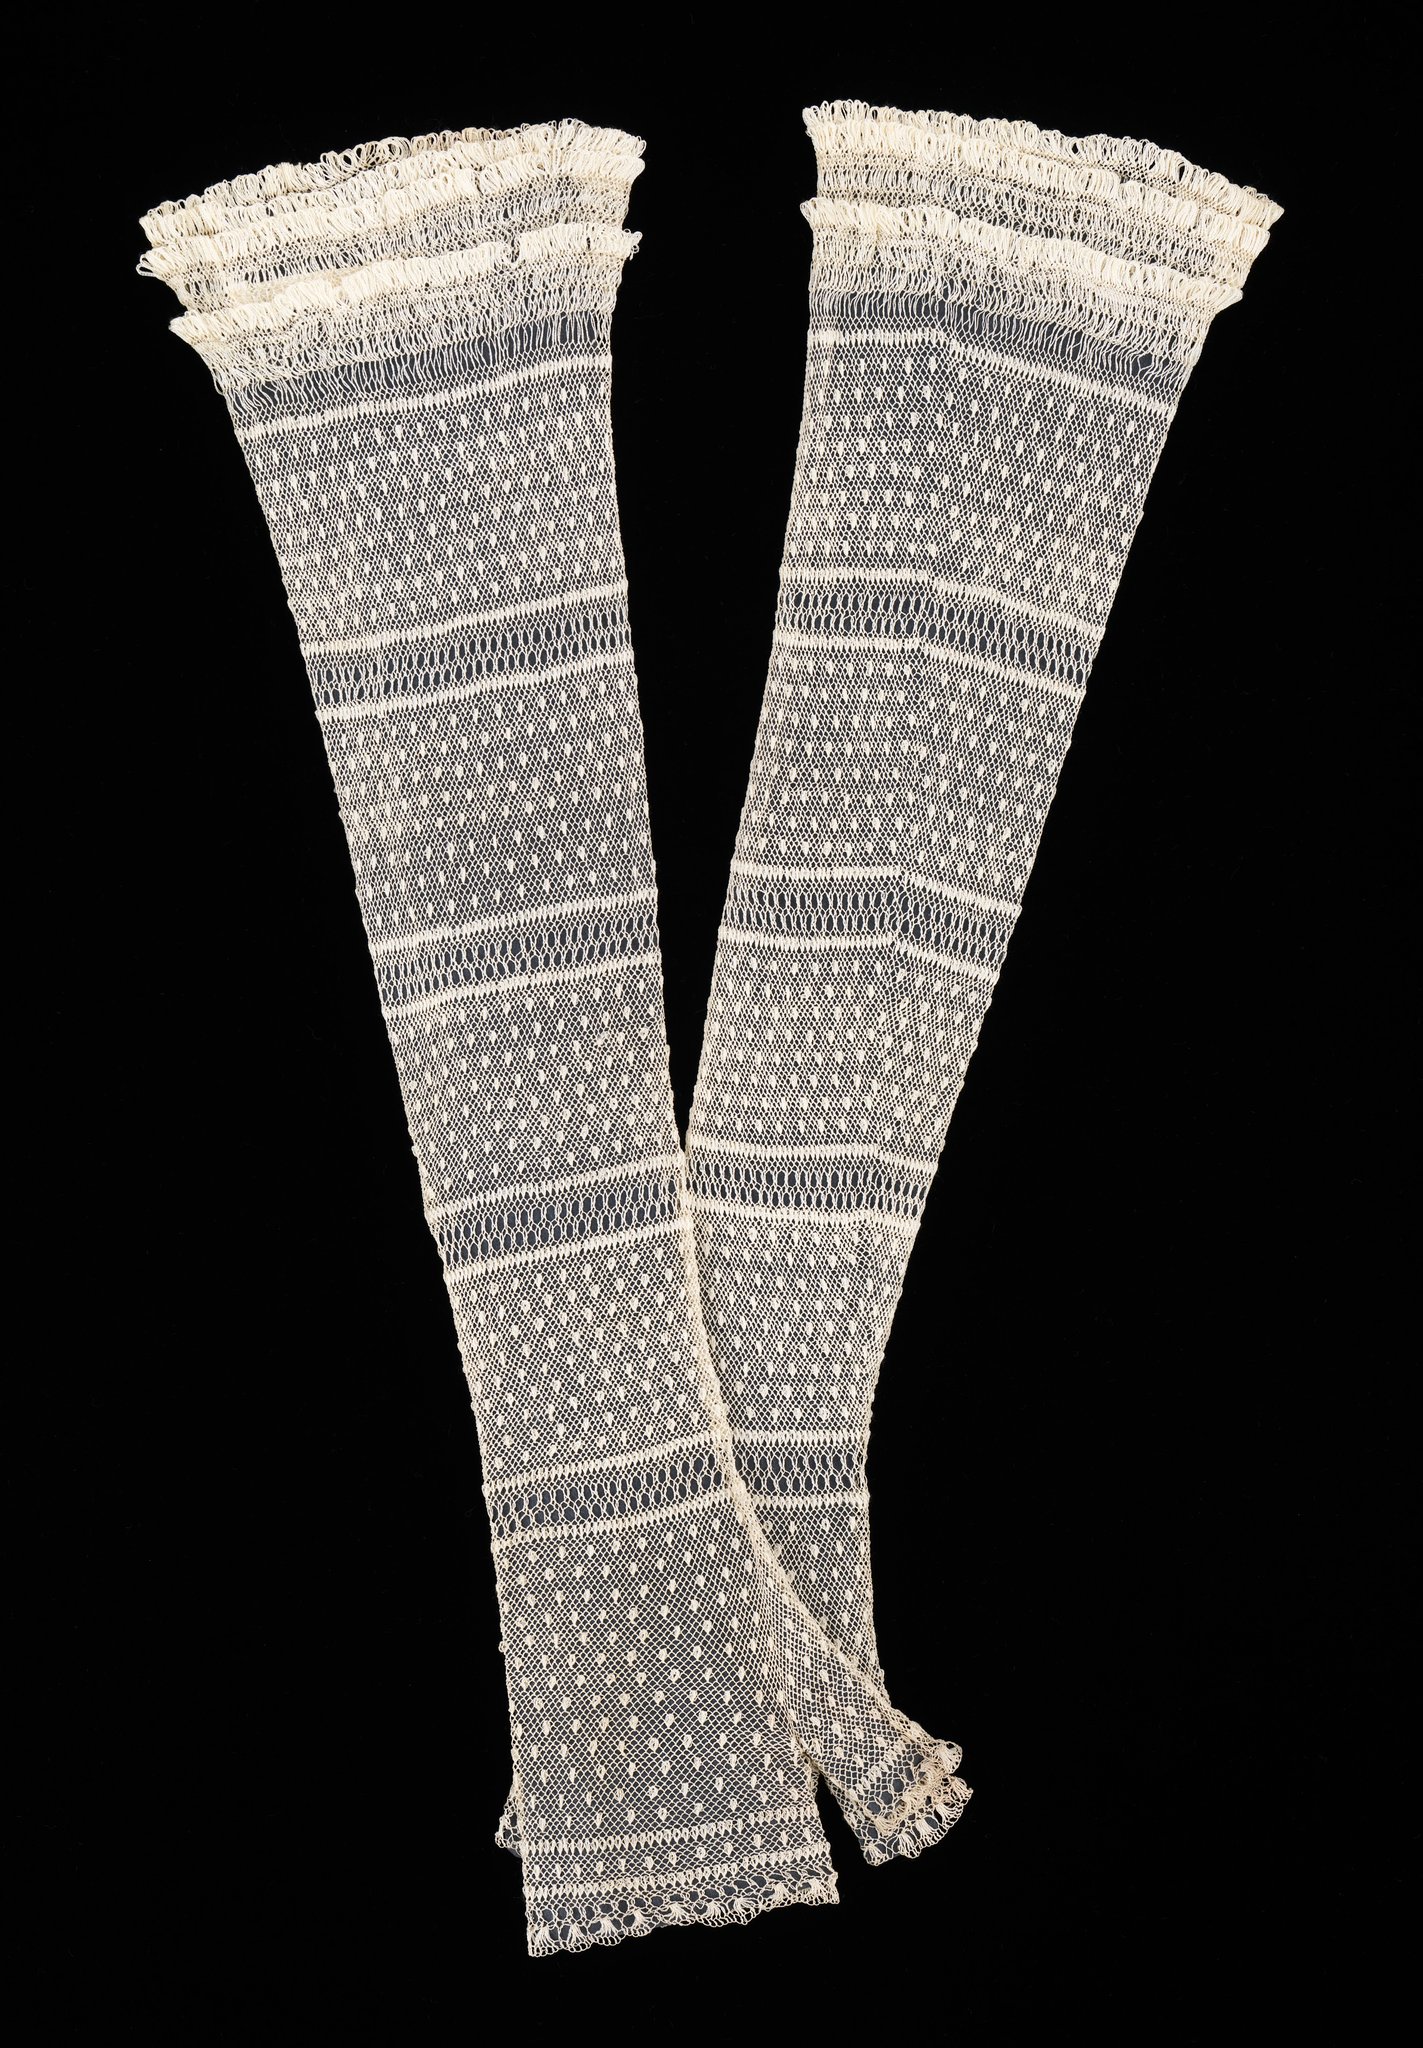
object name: evening mitt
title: Evening mitts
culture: american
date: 1876-1900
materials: silk